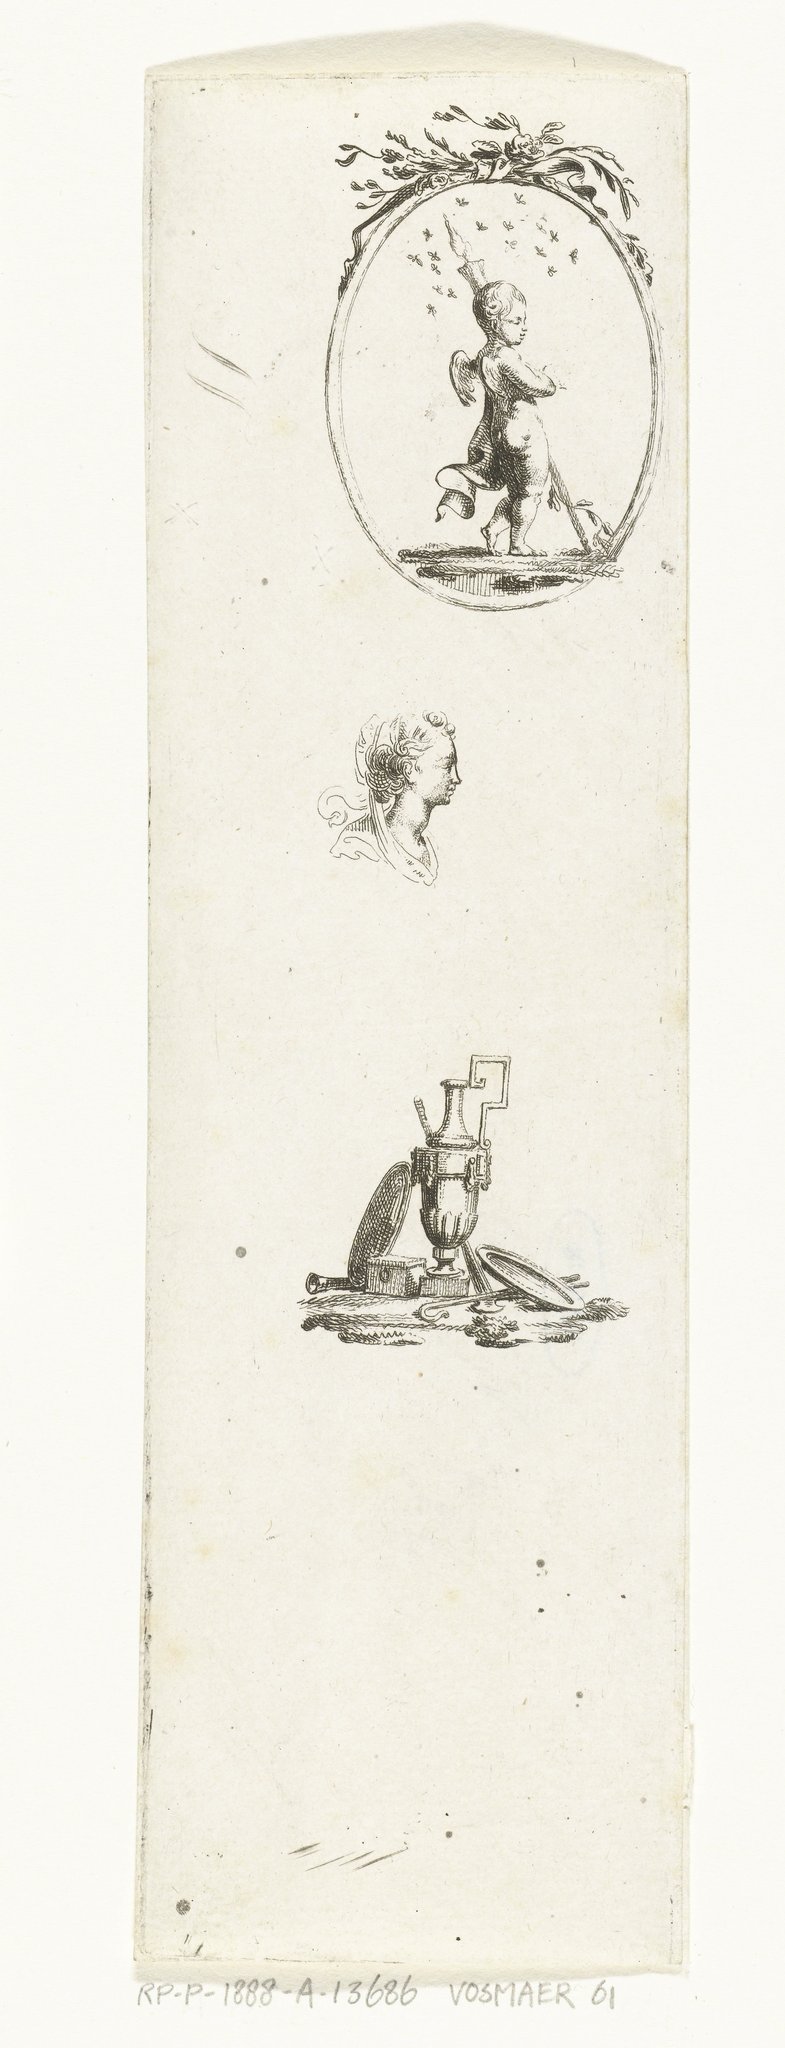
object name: print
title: Blad met drie vignetten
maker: willem bilderdijk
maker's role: draughtsman, print maker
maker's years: 1756-1831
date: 1766-1785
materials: paper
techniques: etching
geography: netherlands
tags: head (human), torch, (story of) cupid, amor (eros), dish, plate, saucer, vignette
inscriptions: collector's mark: Lugt 2228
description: Etsplaat later in losse plaatjes gesneden en afdruk van vignet met Amor gebruikt voor: Bilderdijk, Willem, Bloemtjens, Pieter Johannes Uylenbroek (uitgever), Amsterdam 1785.